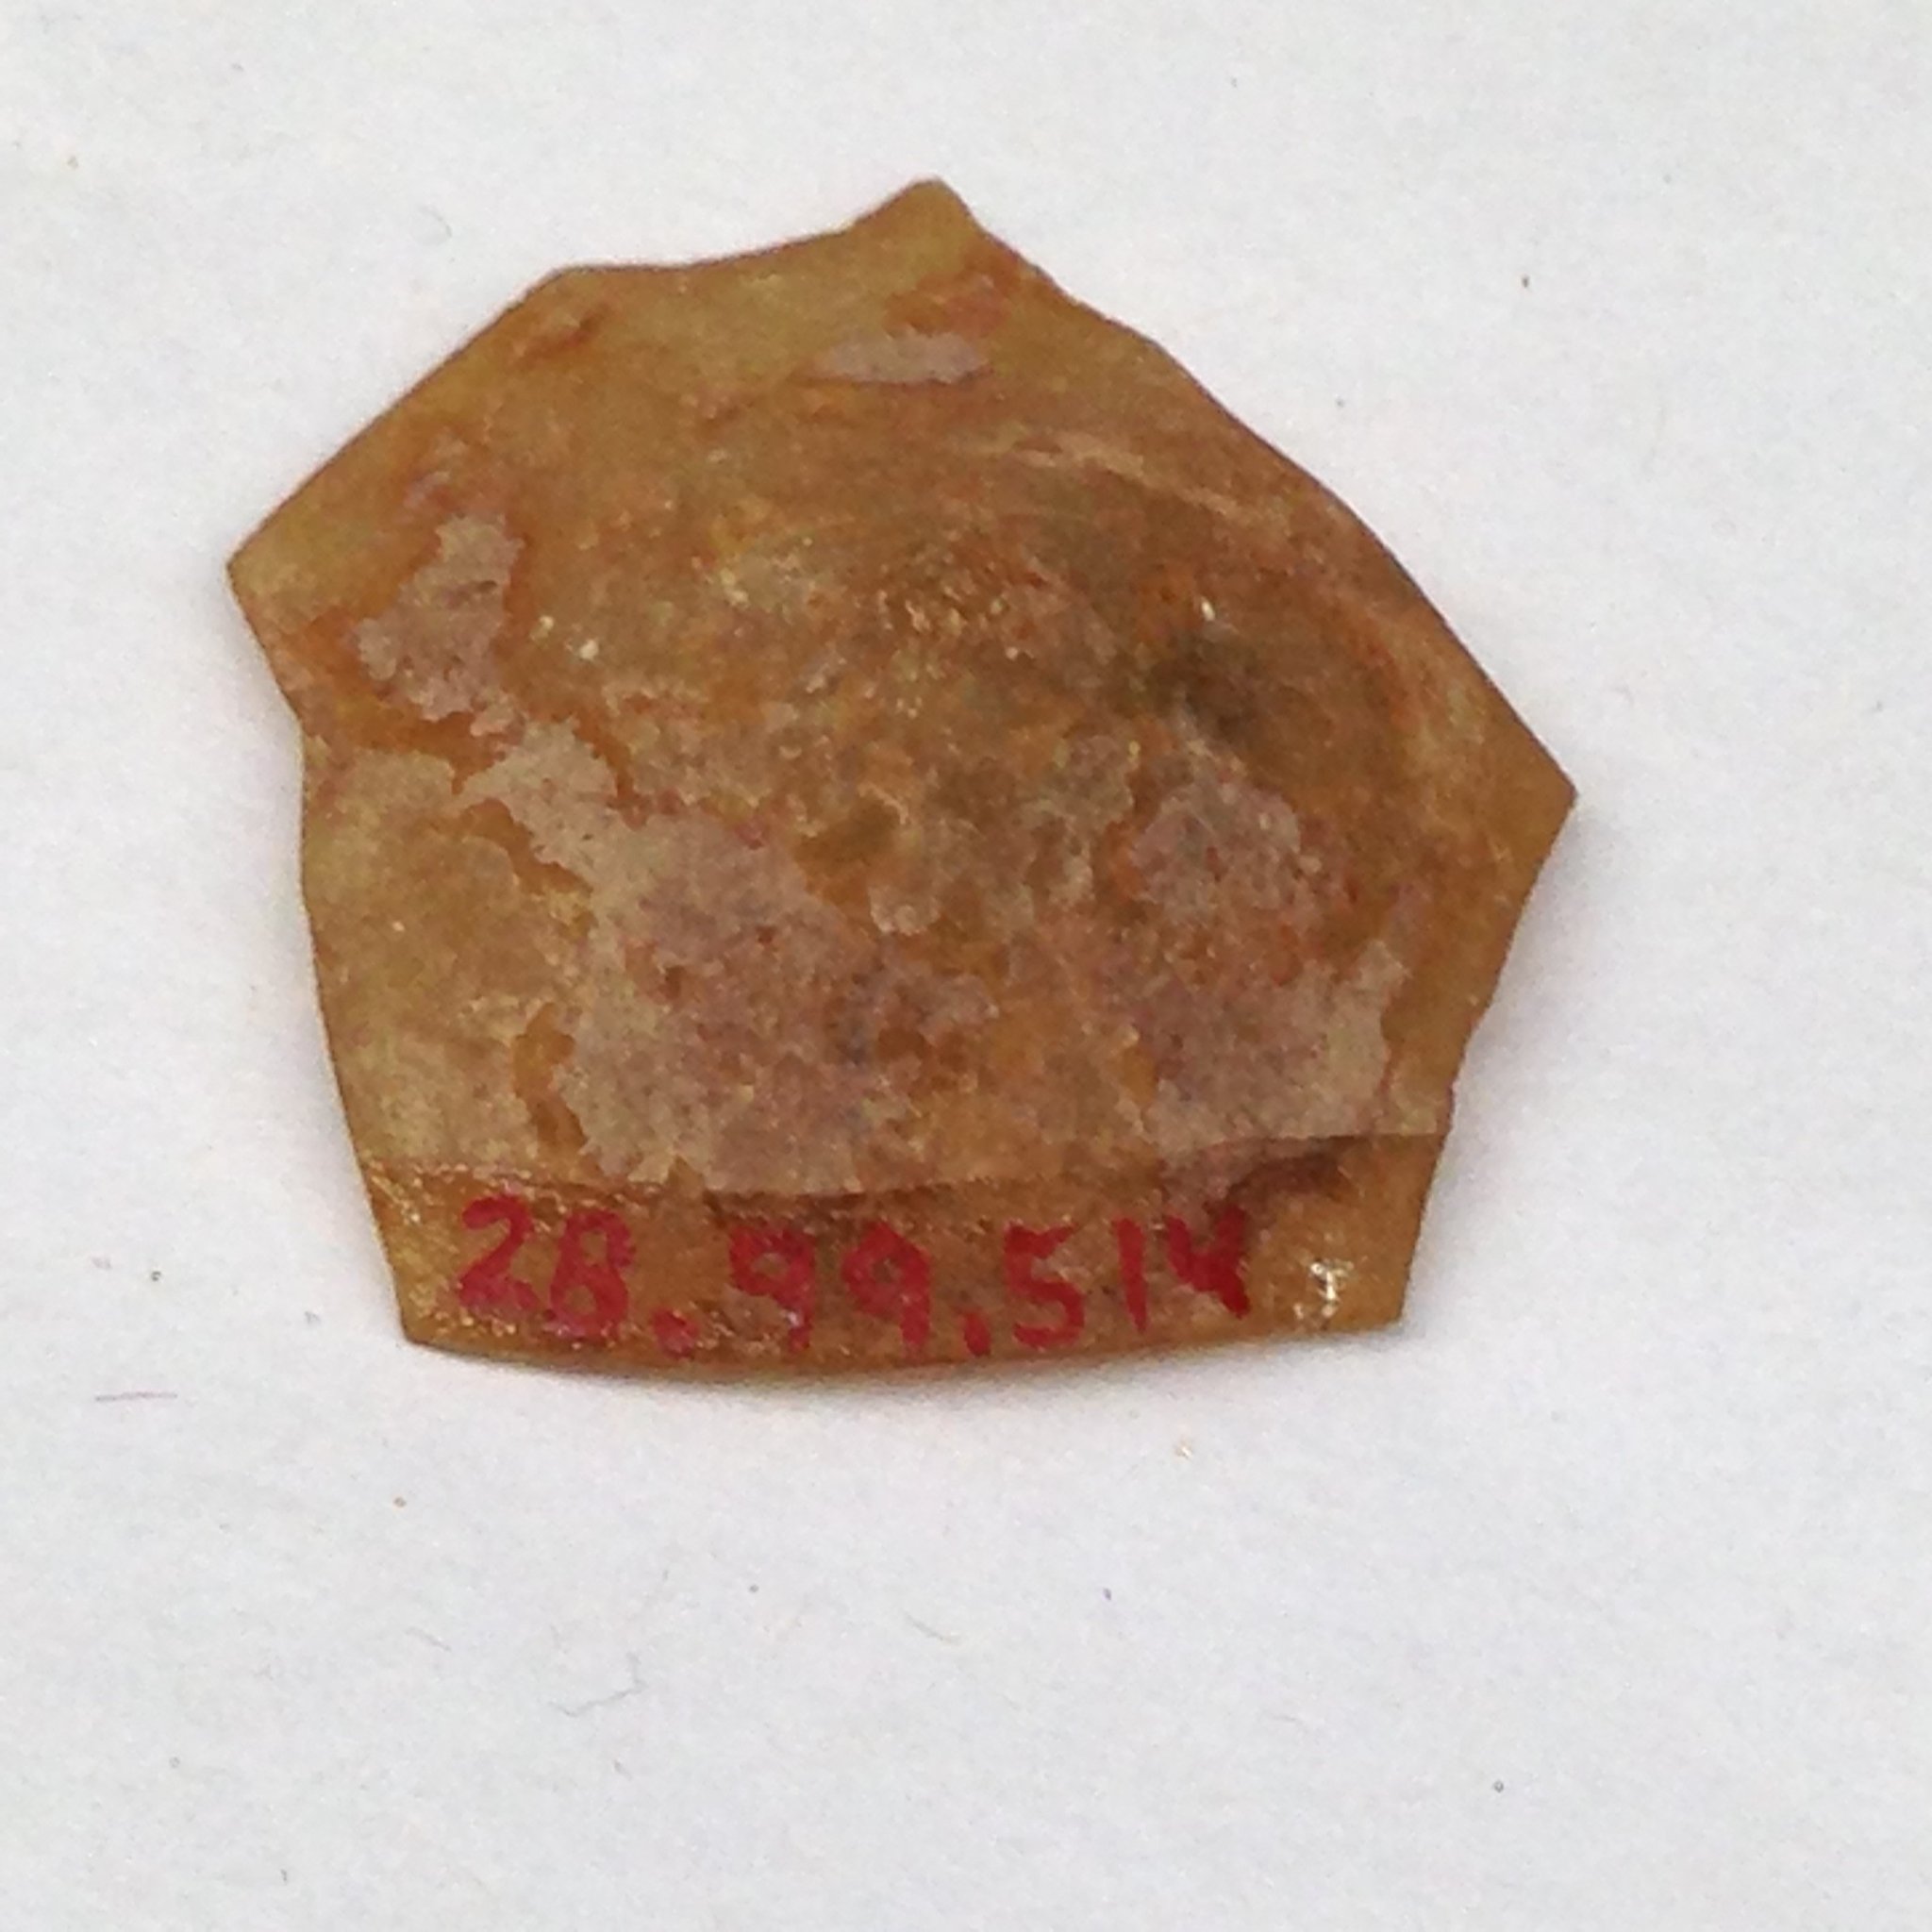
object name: fragment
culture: european or middle eastern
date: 1150-1250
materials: ceramic, glass